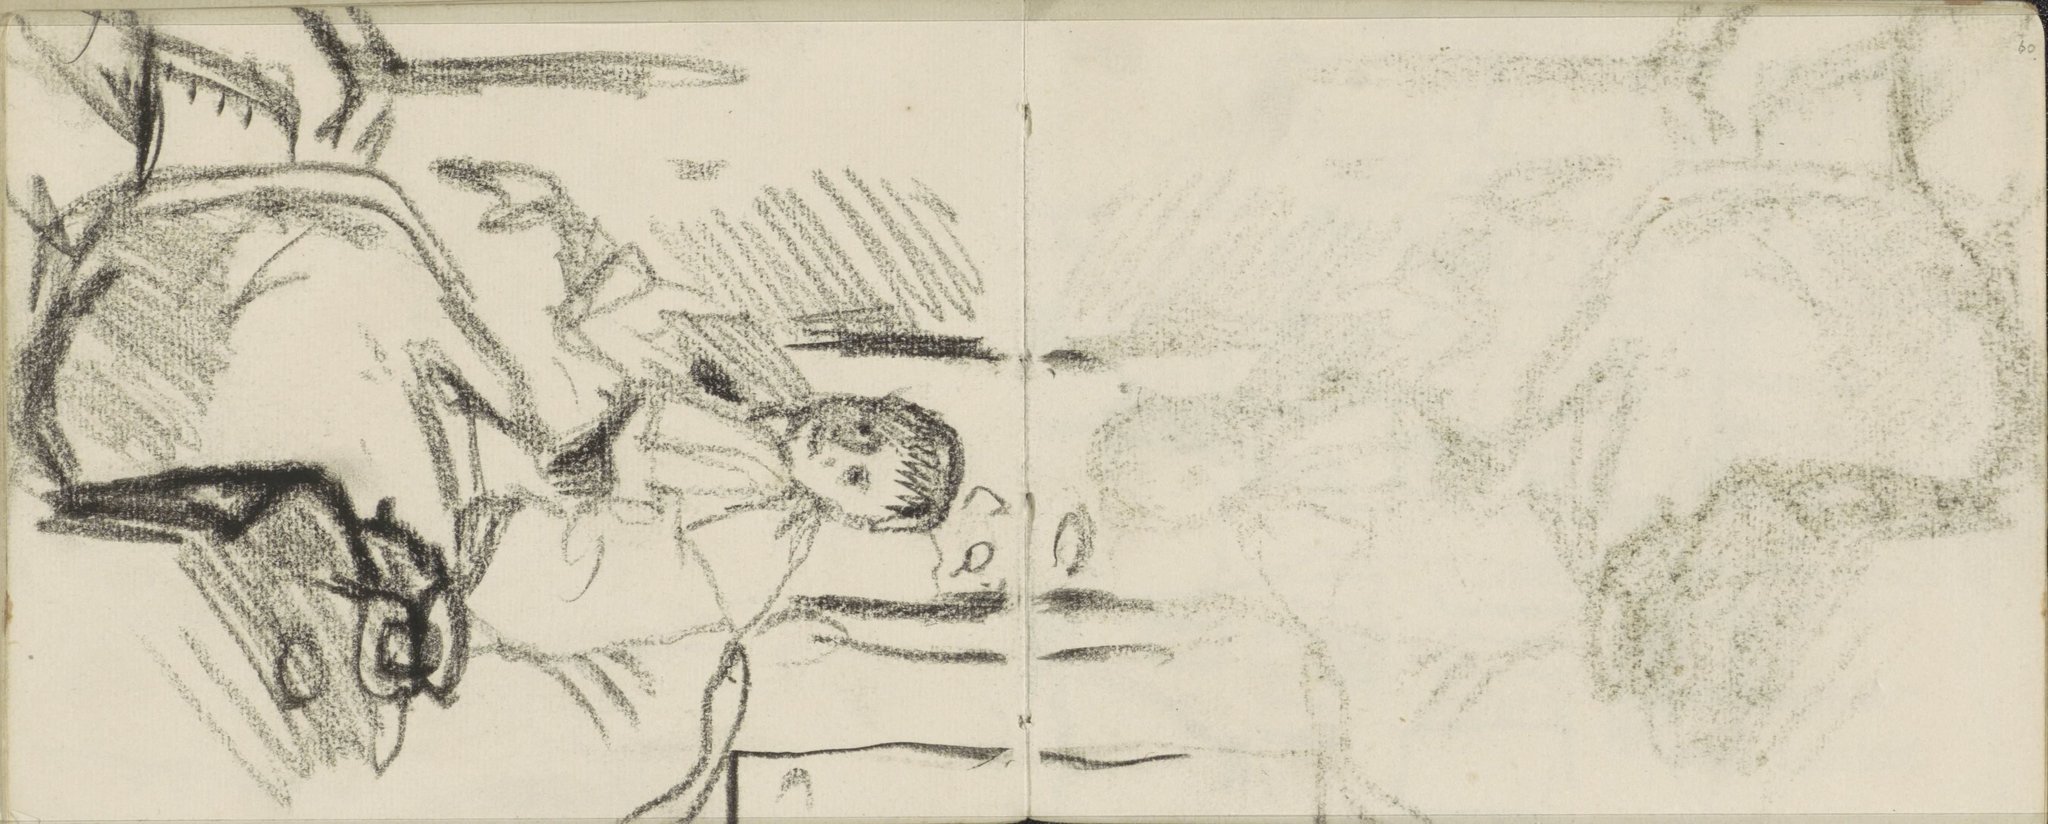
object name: sketchbook leaf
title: Zittende vrouw in interieur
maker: george hendrik breitner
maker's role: draughtsman, painter, print maker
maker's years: 1857-1923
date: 1886-1903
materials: chalk, paper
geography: amsterdam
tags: interior of the house, sitting on an elevation - aa - female human figure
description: Pagina 59 en pagina 60 uit een schetsboek met 32 bladen.